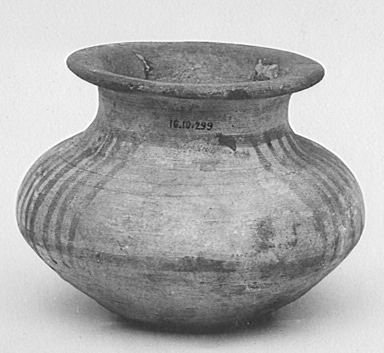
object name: jar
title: Pot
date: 1635-1458 BCE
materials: paint, pottery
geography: egypt